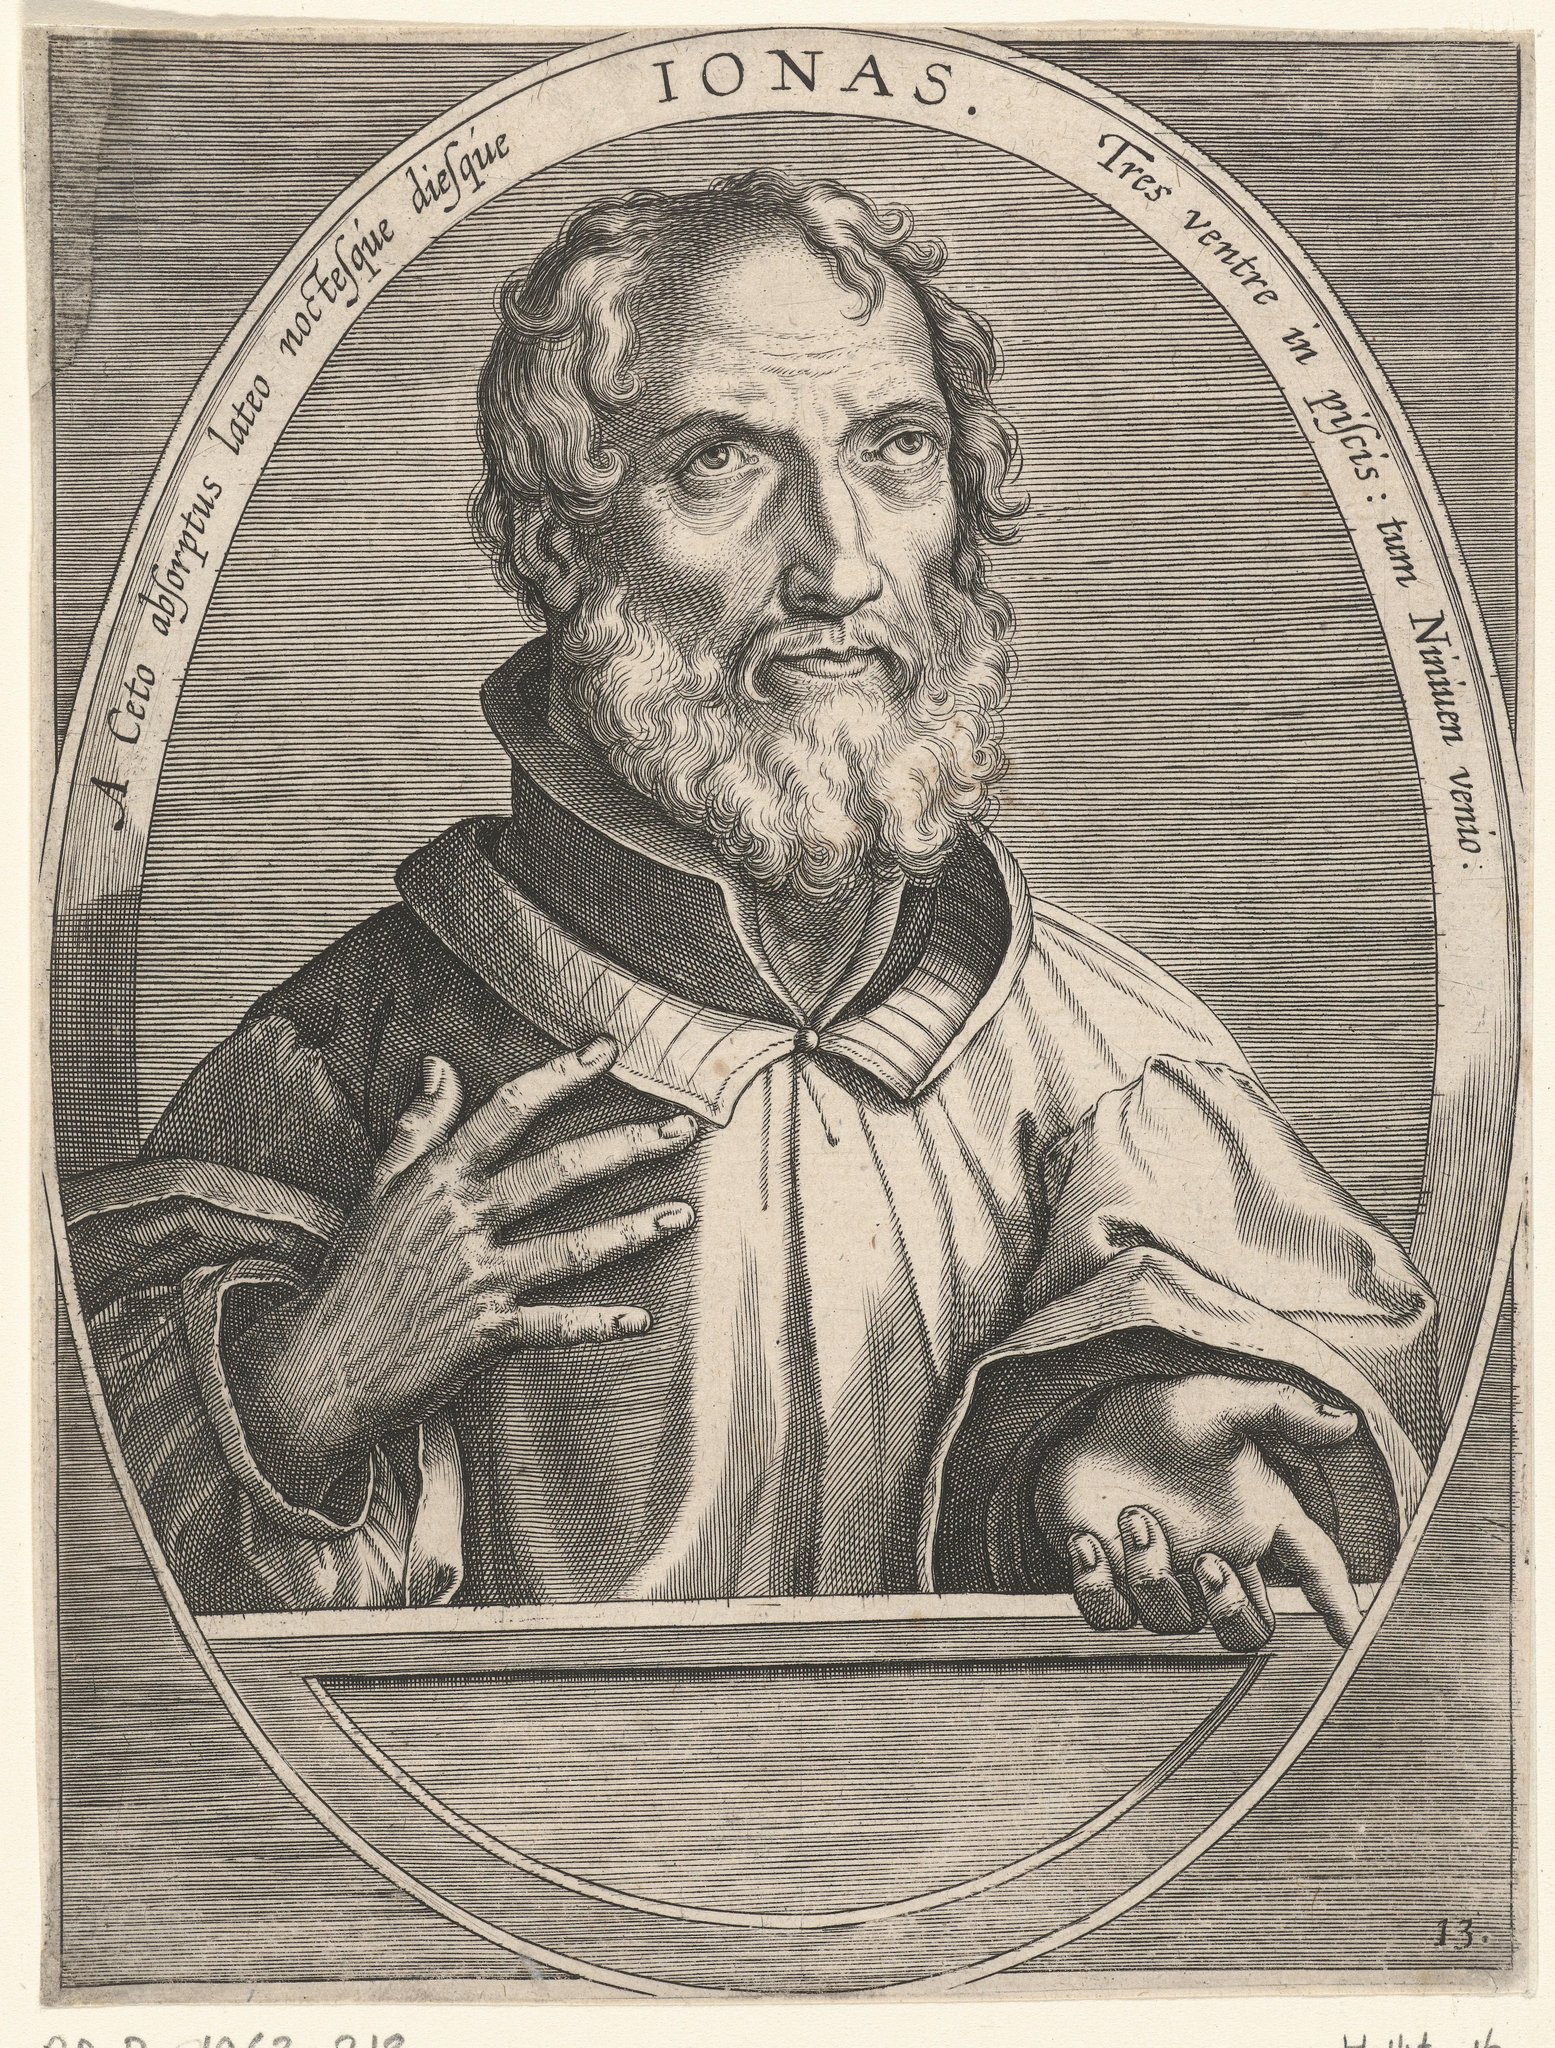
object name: print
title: Icones Prophetarum Veteris Testamenti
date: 1613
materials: paper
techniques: engraving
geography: antwerp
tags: the book of jonah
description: De profeet Jona , in ovaal met Latijns randschrift.